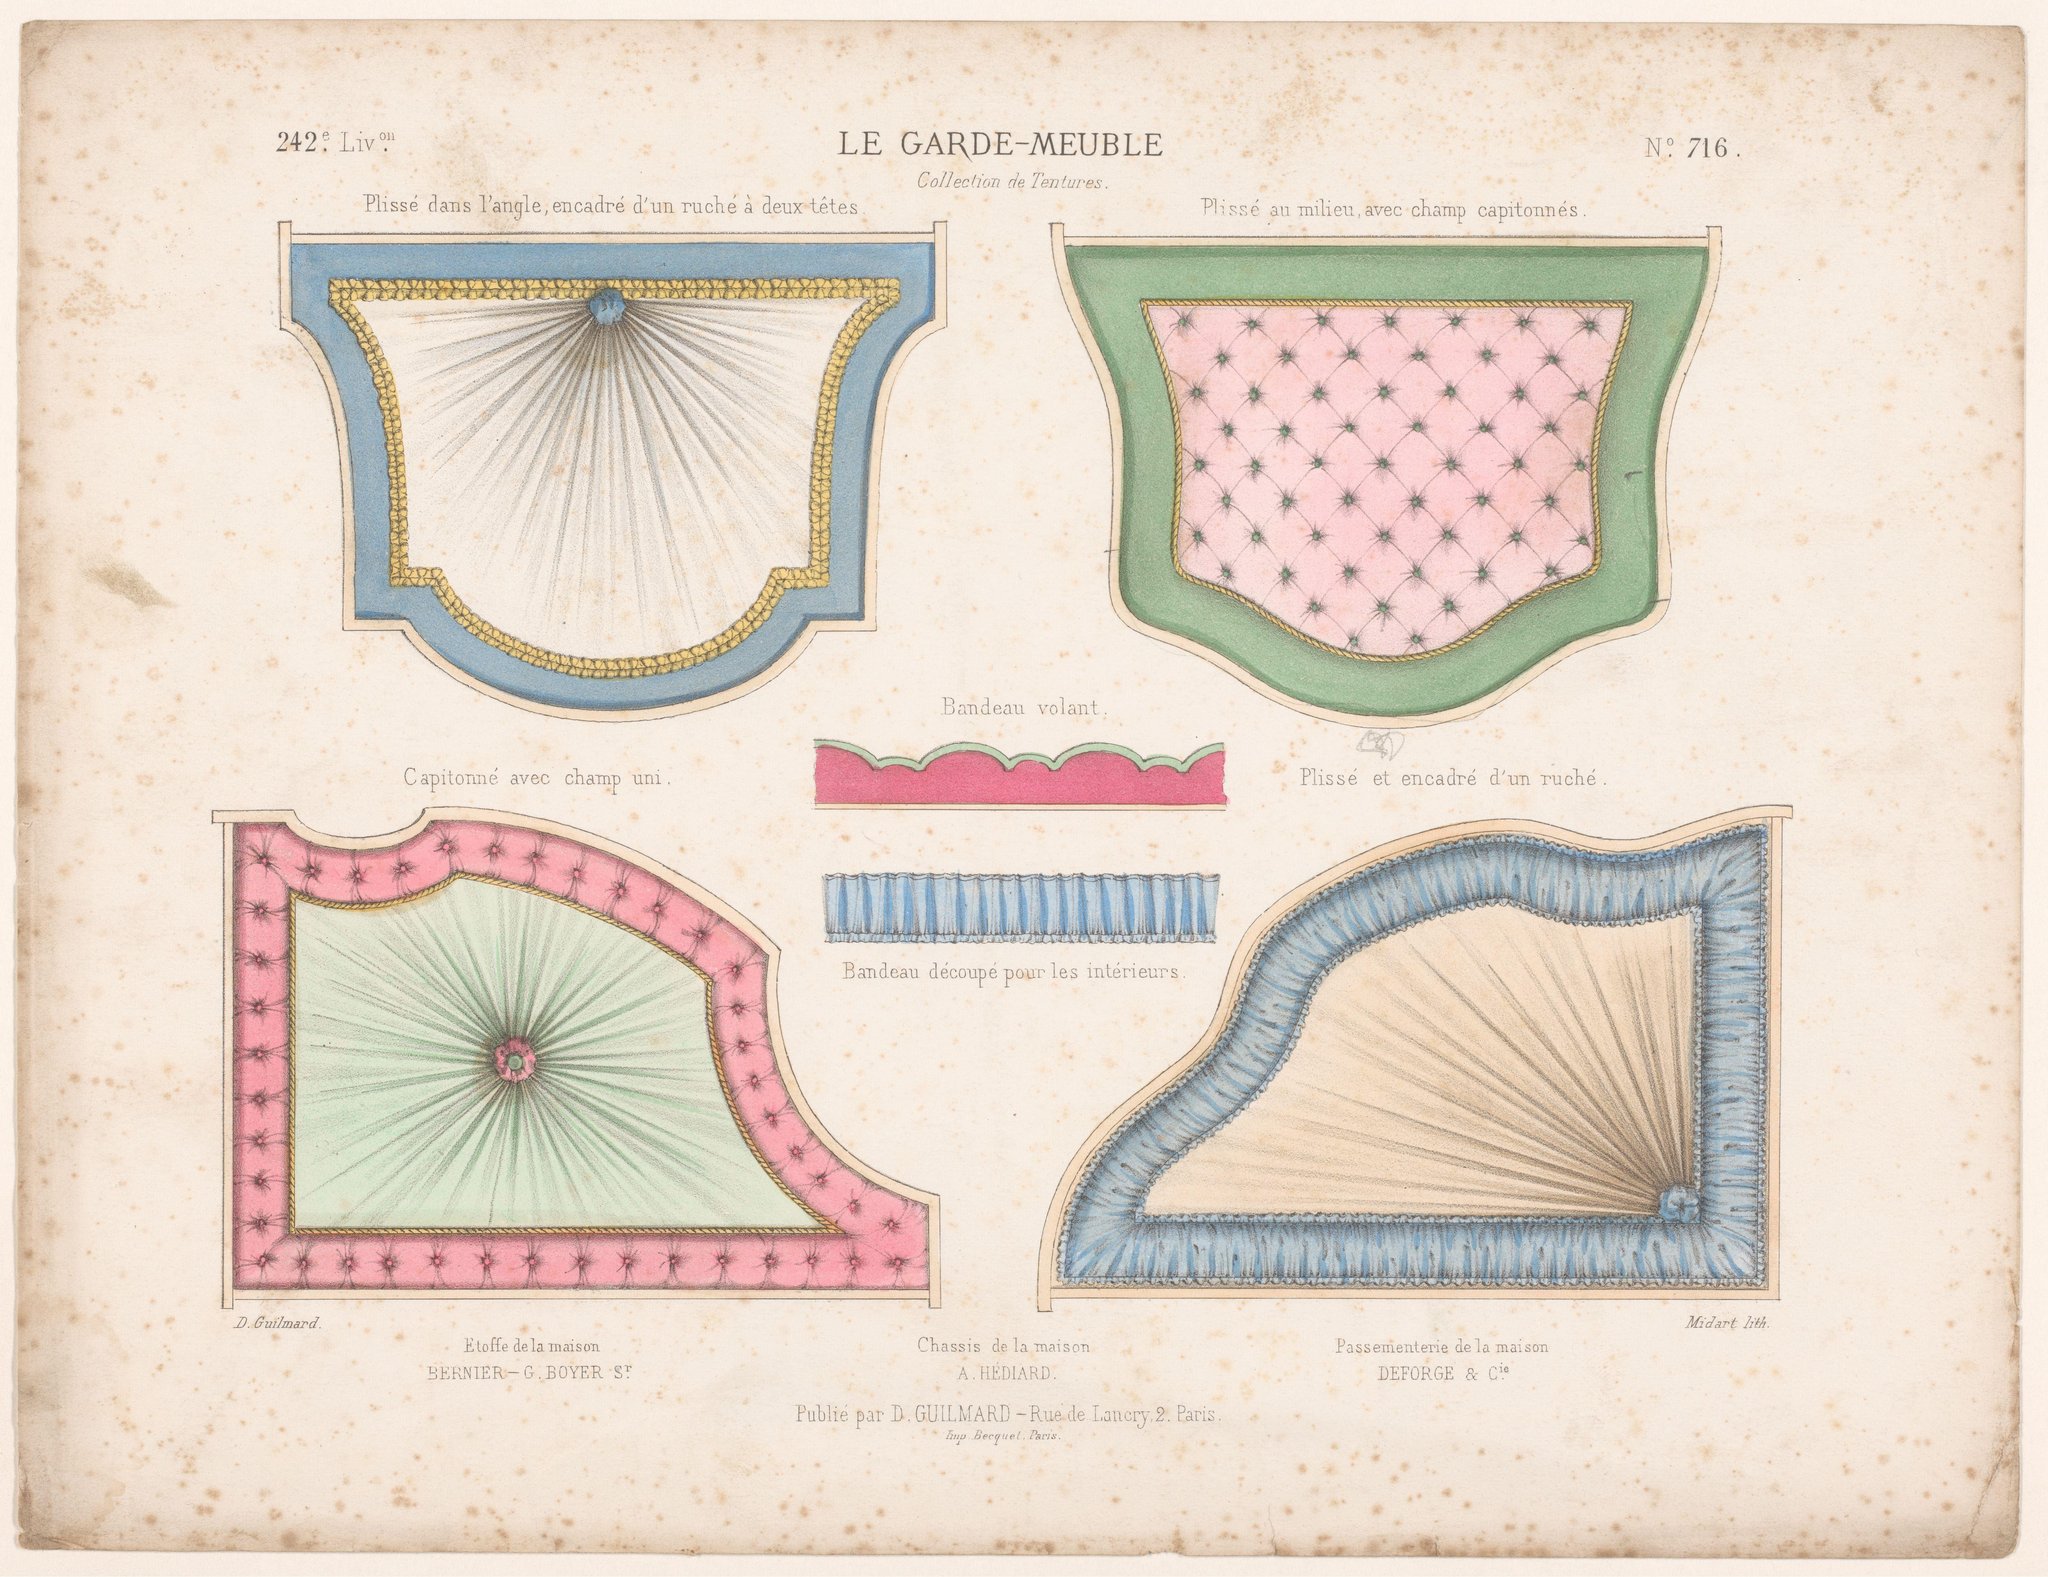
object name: print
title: Le Garde-Meuble / Collection de Tentures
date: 1860-1880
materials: paper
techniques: hand coloring, lithograph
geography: paris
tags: hangings and drapery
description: Diverse voorbeelden van plooi- en stoffeertechnieken. Prent uit 242e Livraison.